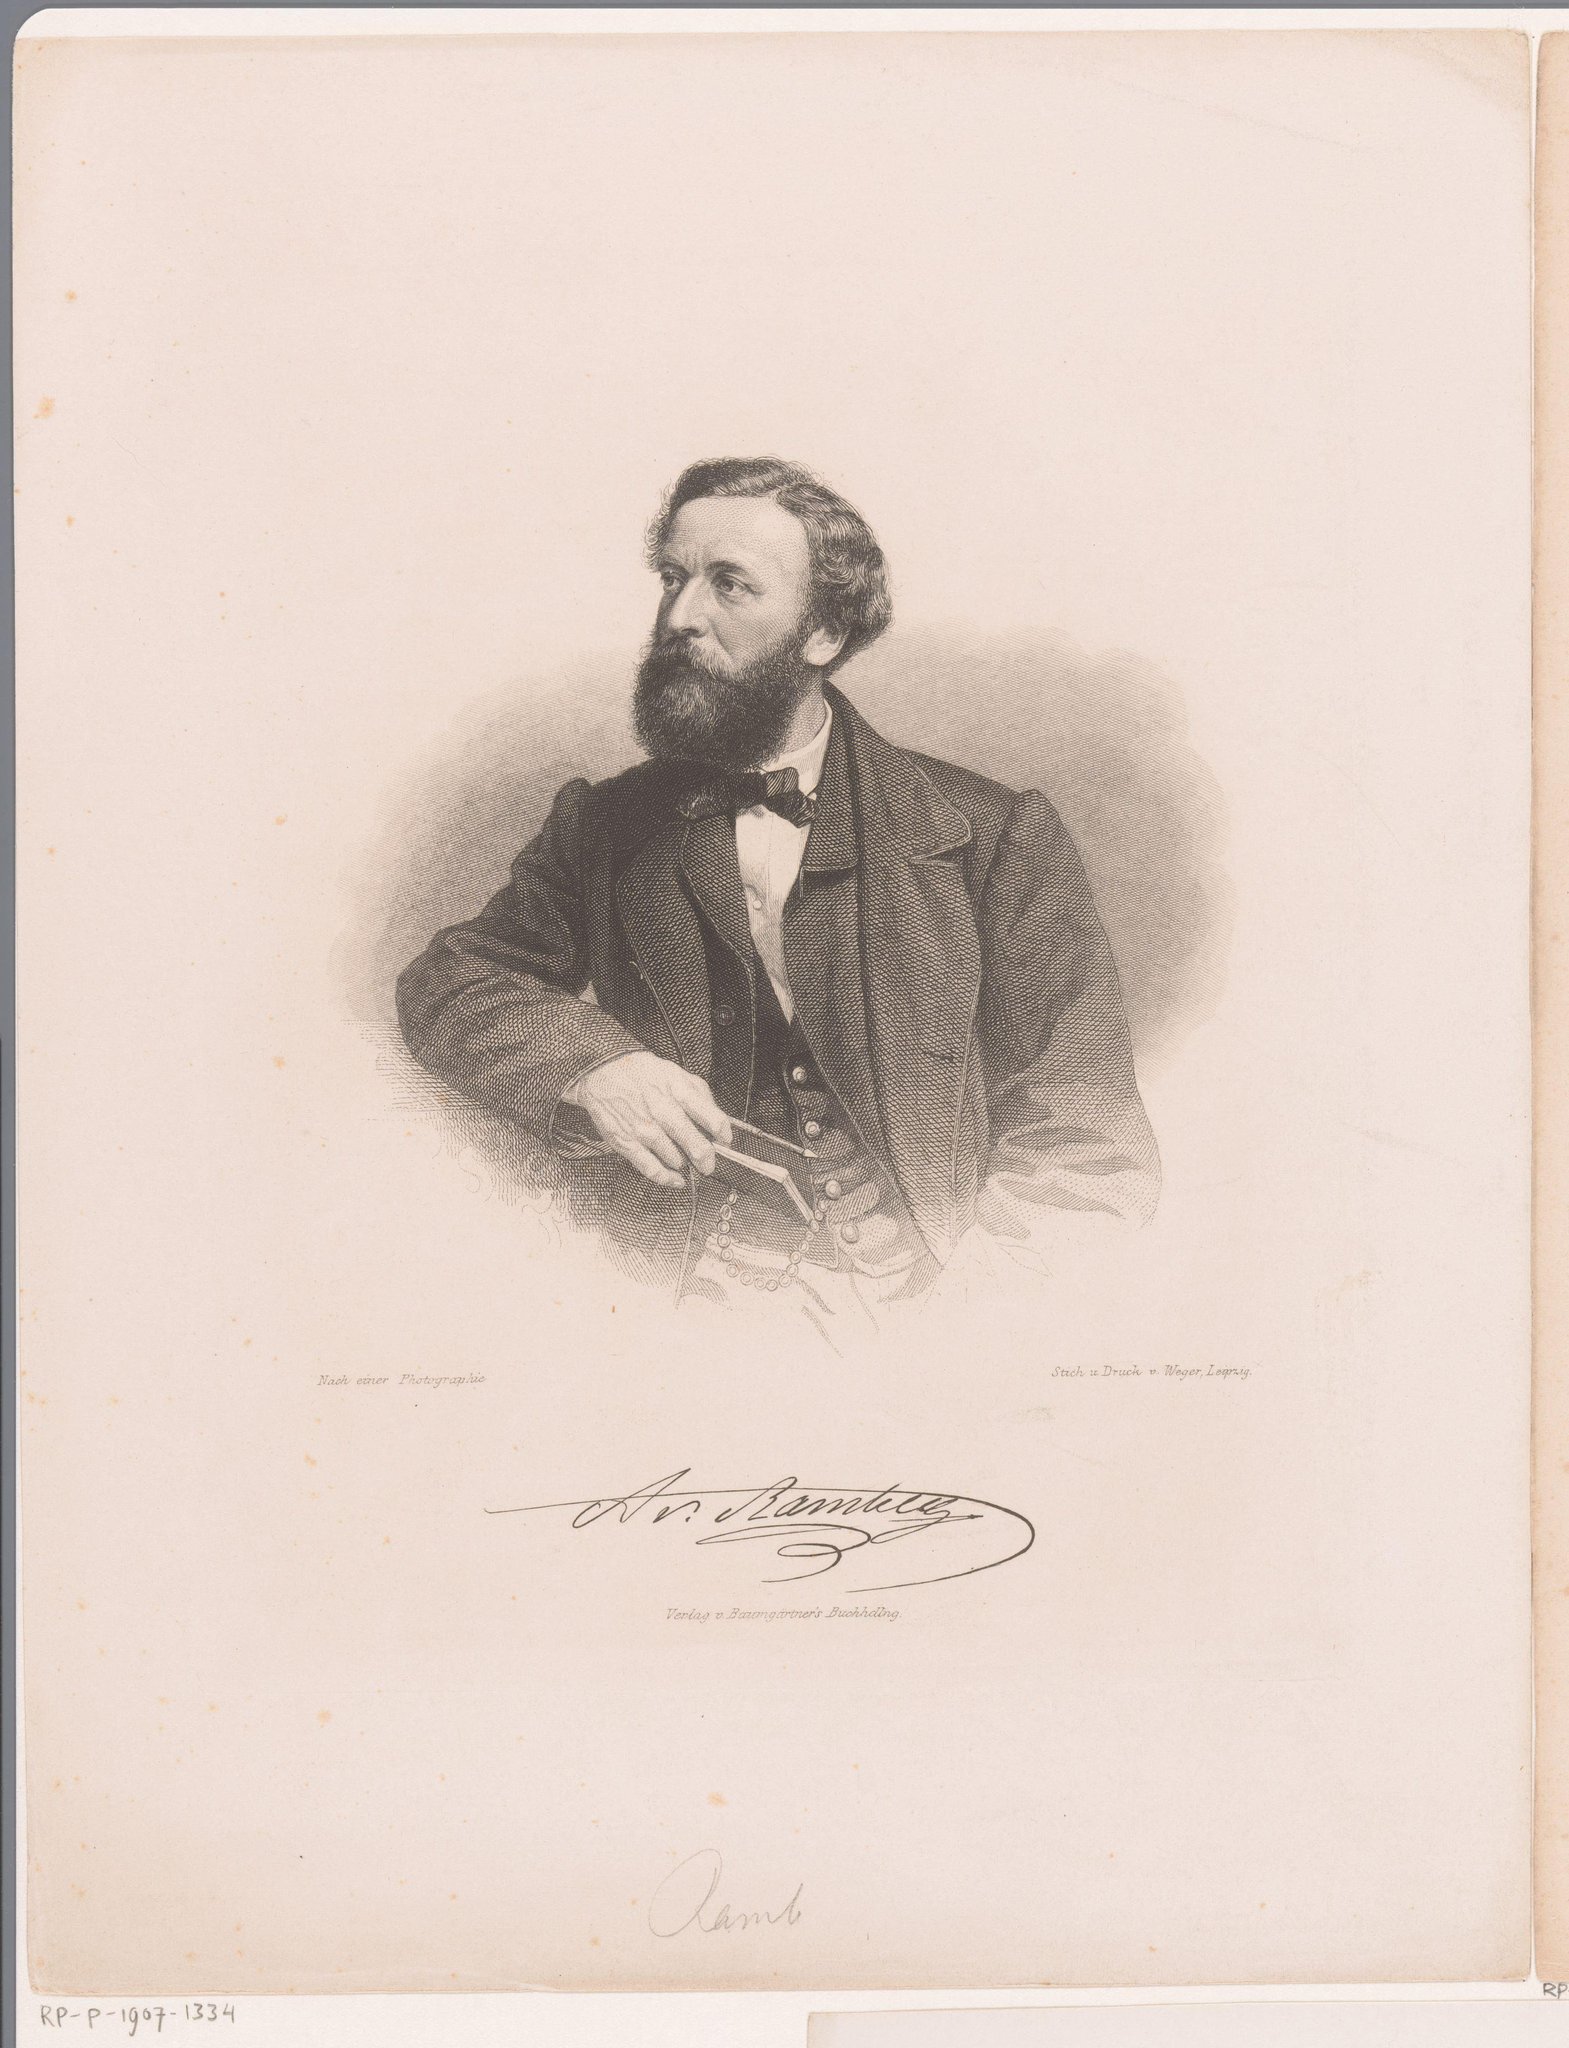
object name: print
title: Portret van Arthur Georg von Ramberg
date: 1860-1892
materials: paper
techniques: engraving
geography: leipzig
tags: painter, arthur georg von ramberg, historical persons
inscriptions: collector's mark: Lugt 2228